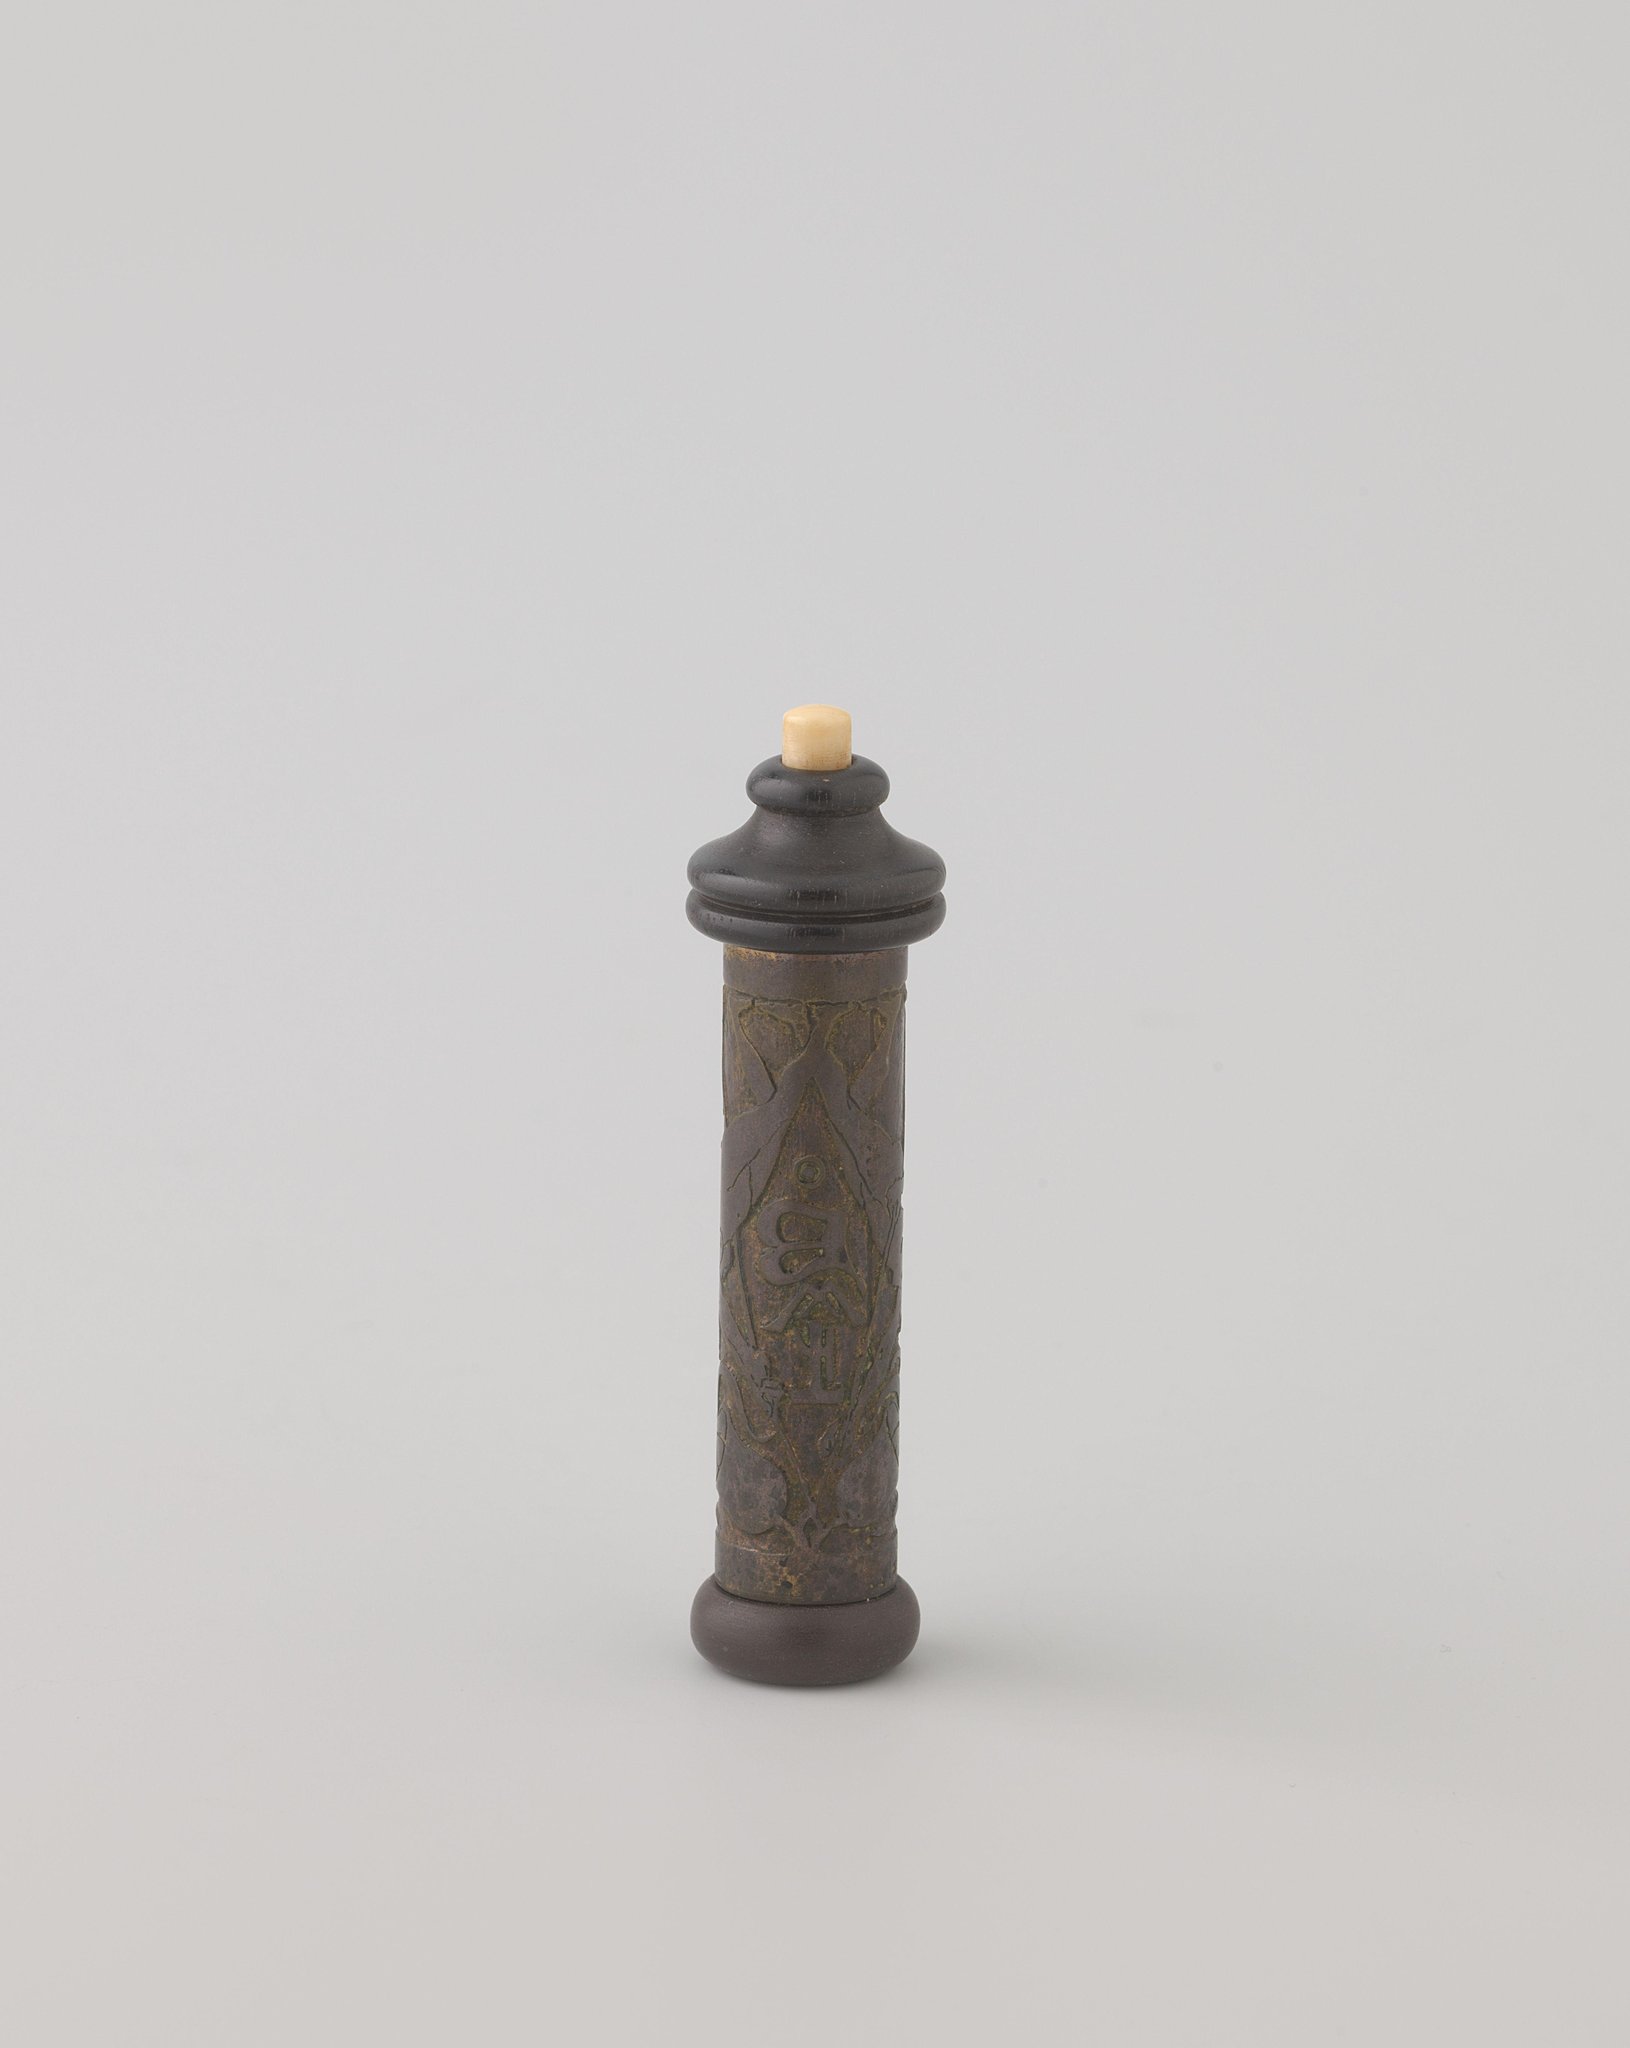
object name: schel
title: Kamerschel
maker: Anonymous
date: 1900-1910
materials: copper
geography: netherlands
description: Kamerschel. Horend bij de betimmering van T. Nieuwenhuis, afkomstig uit het Huis 't Uiltje te Loenen-Nieuwersluis (zie ook BK-1970-93).